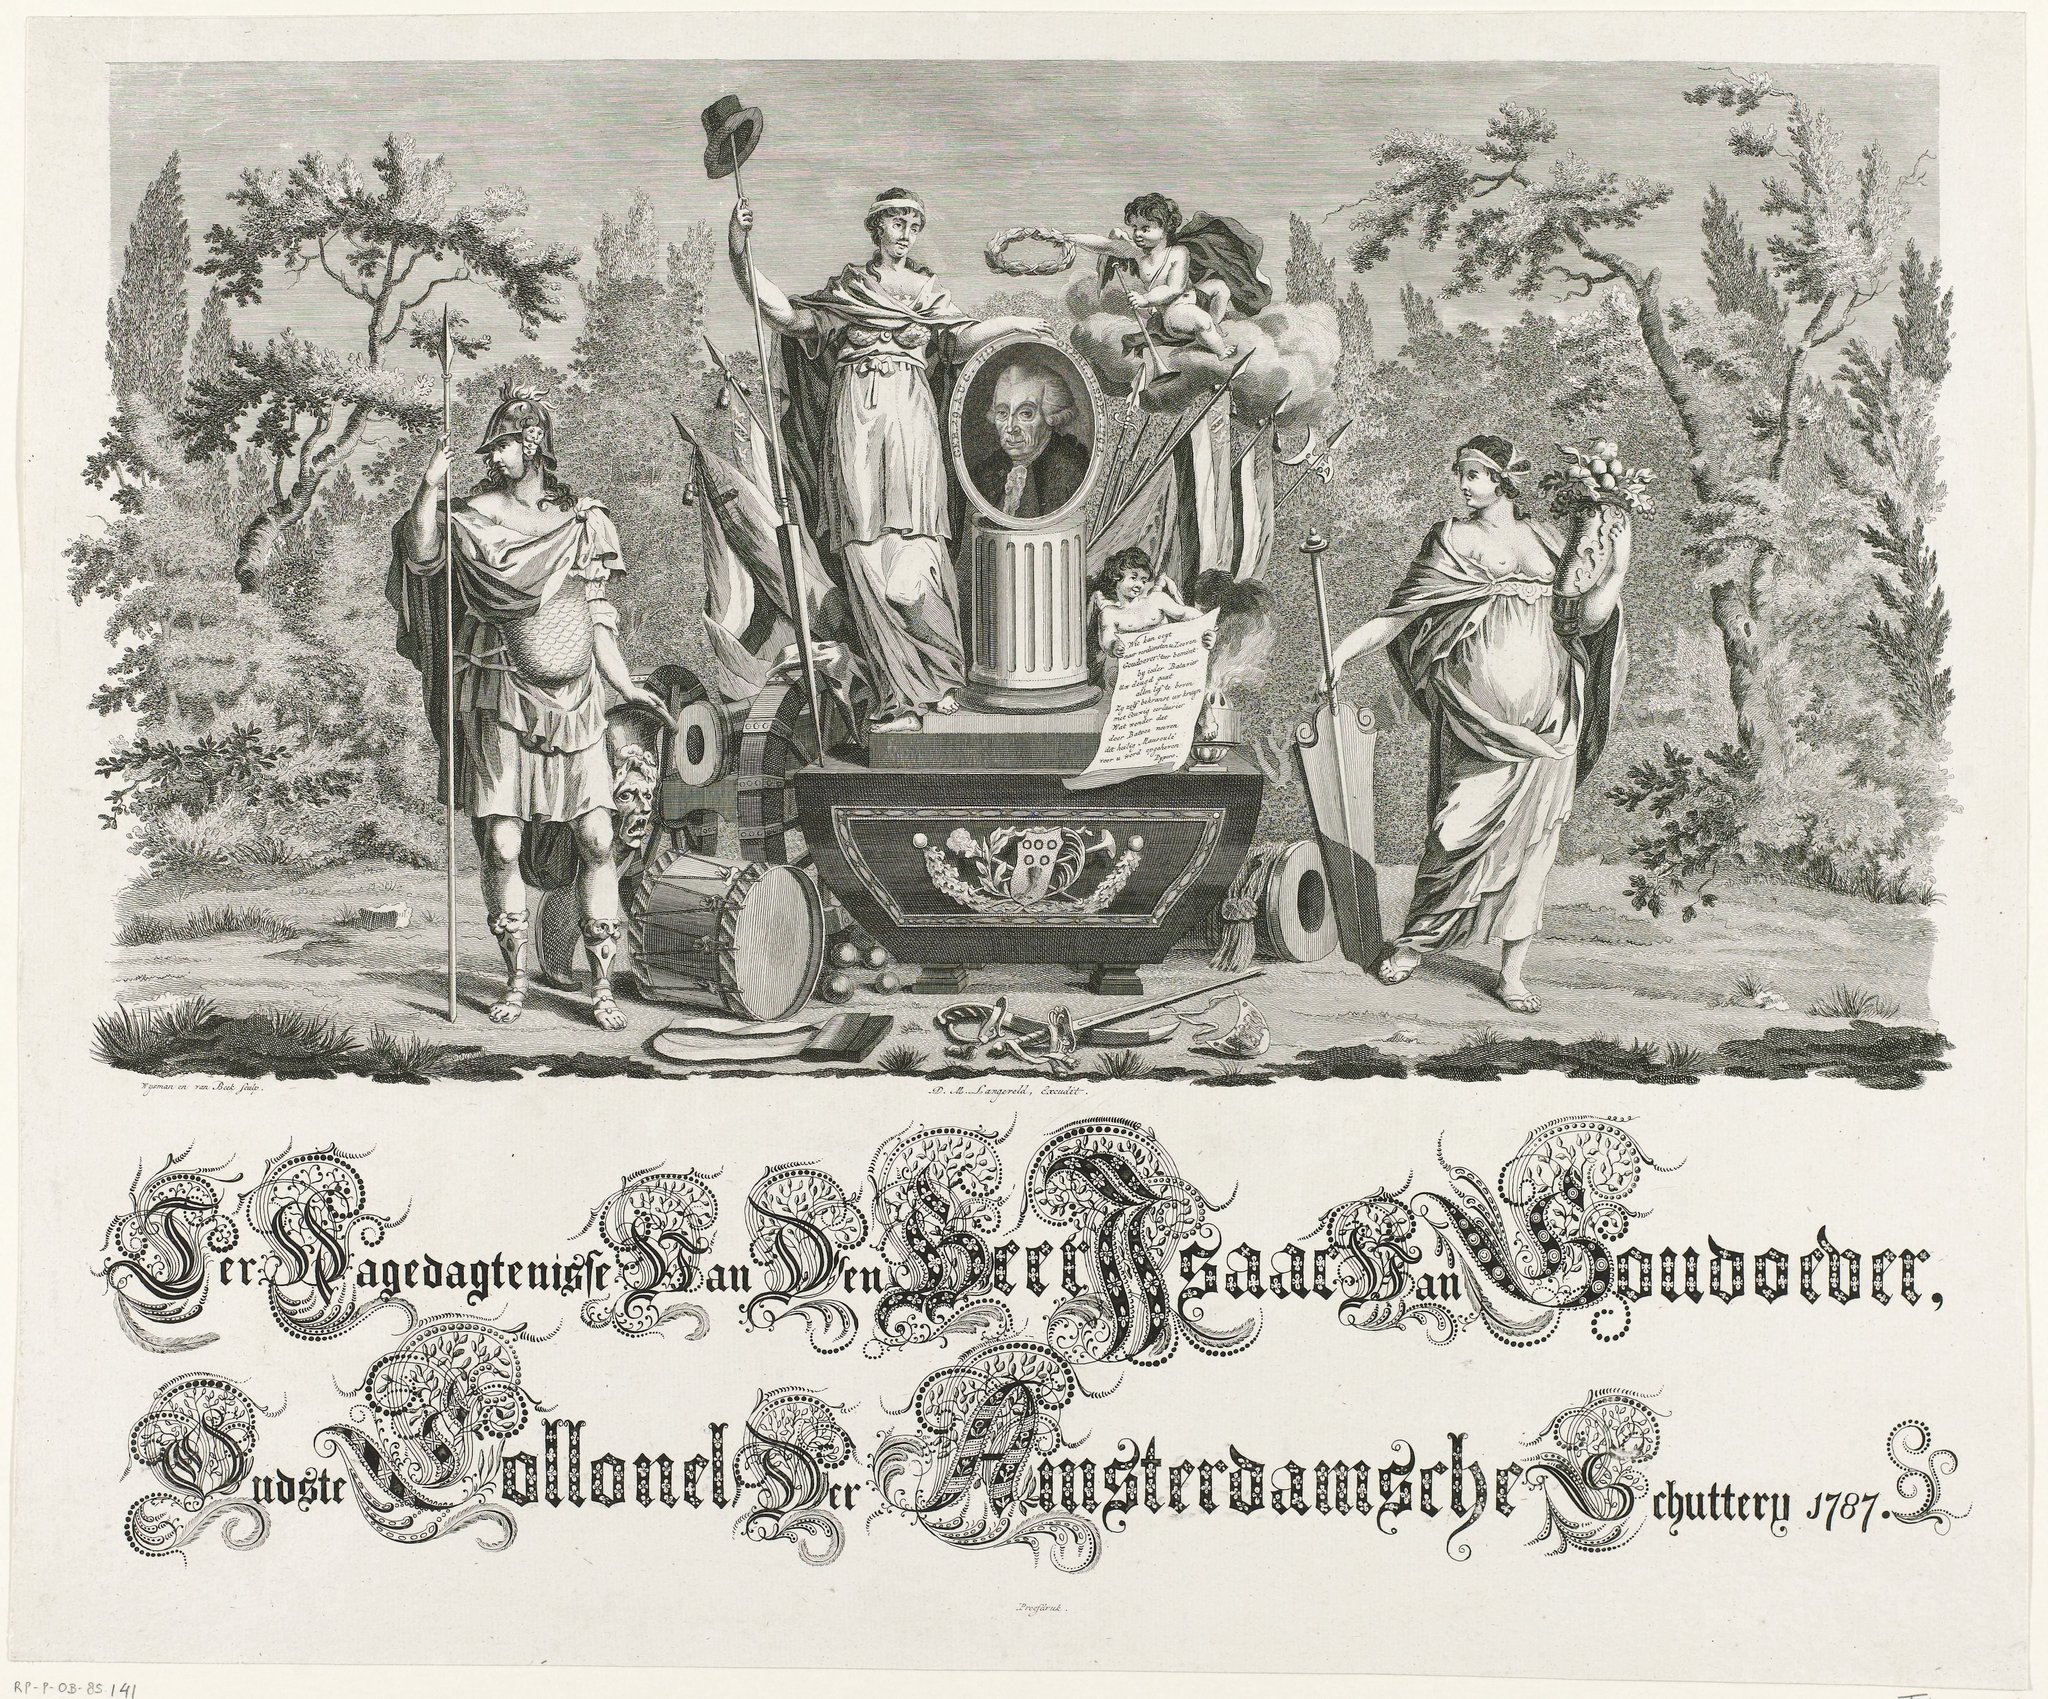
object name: print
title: Ter Nagedagtenisse van den Heer Isaac van Goudoever, Oudste Kollonel der Amsterdamsche Schuttery 1787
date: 1793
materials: paper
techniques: engraving, etching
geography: northern netherlands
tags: amsterdam, calligraphy, grave-building, monumental tomb, freedom, liberty; 'libertà' (ripa) (+ abstract concept represented by female figure), patriots (1780-1795)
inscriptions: collector's mark: Lugt 2228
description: Allegorisch grafmonument voor Isaak van Goudoever, overleden op 11 september 1793. Op het graf de Vrijheid met haar hand rustend op het portret van Goudoever op een afgebroken zuil. Links van de graftombe staat Minerva, rechts een allegorisch vrouwenfiguur met roer en hoorn van overvloed. Onder de voorstelling de gekalligrafeerde titel. Pendant van de prent met grafmonument voor Henrik Hooft Danielsz. in 1794.